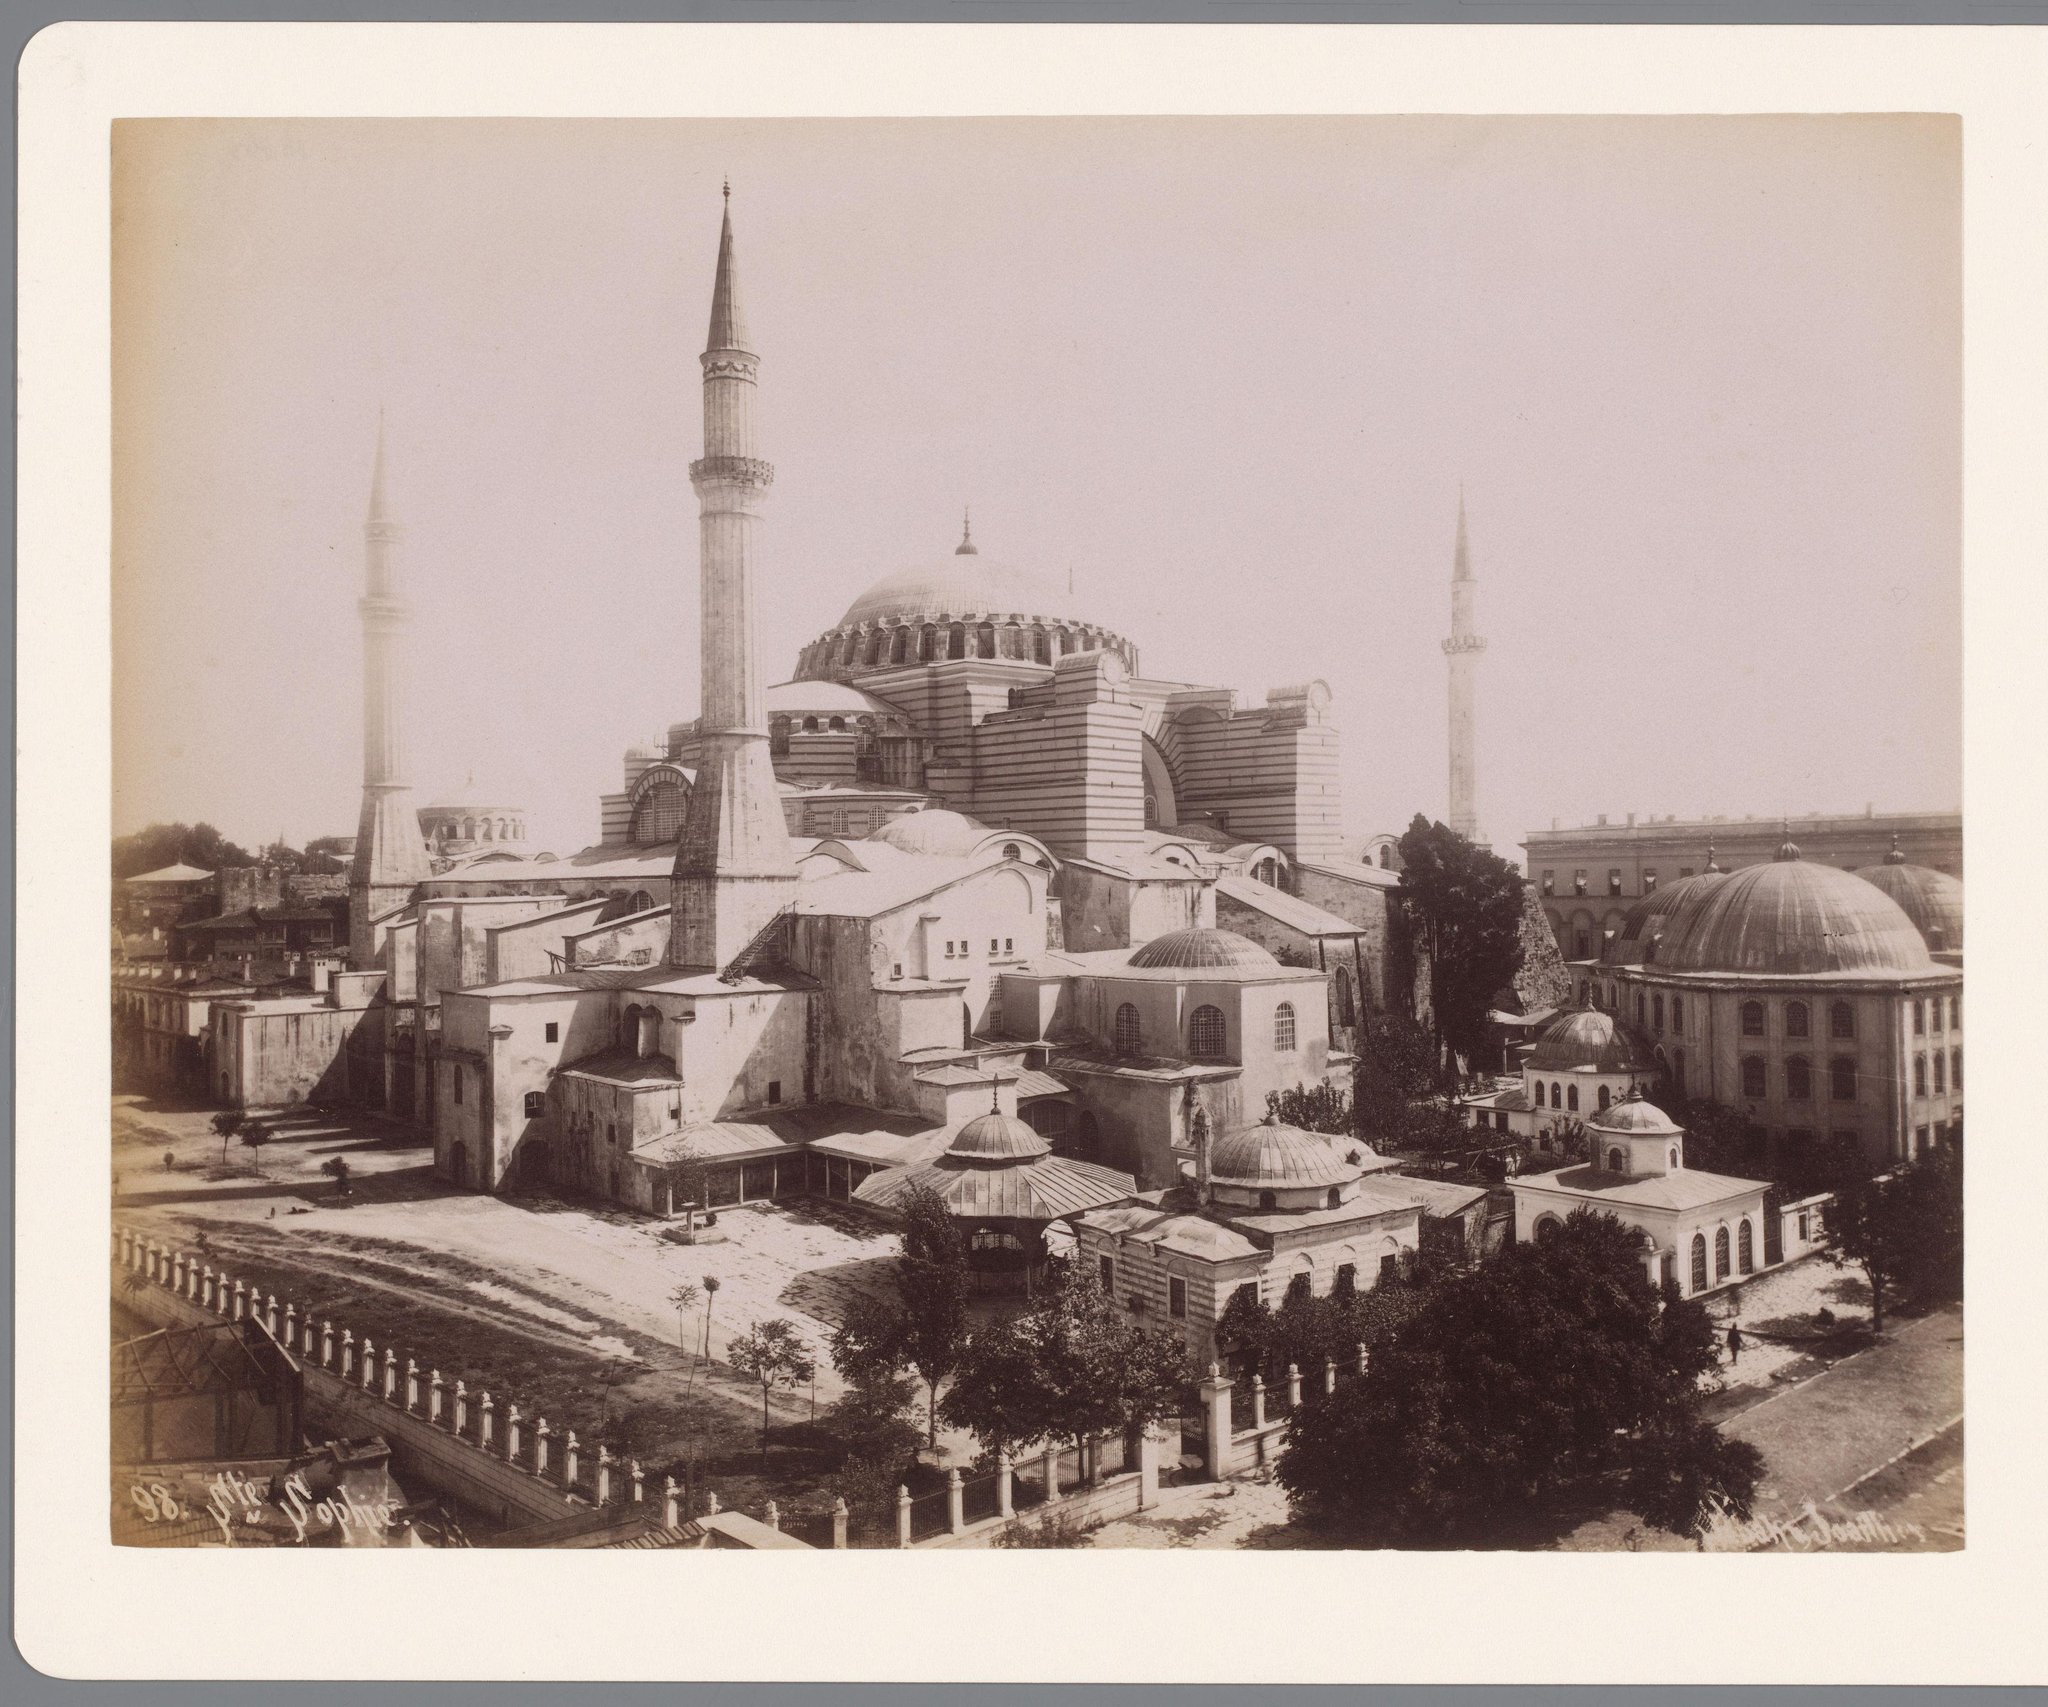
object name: photograph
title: Ste Sophie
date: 1888-1900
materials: paper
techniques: albumen print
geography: istanbul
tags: temple, shrine ~ islam, mohammedanism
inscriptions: number: ‘98.’